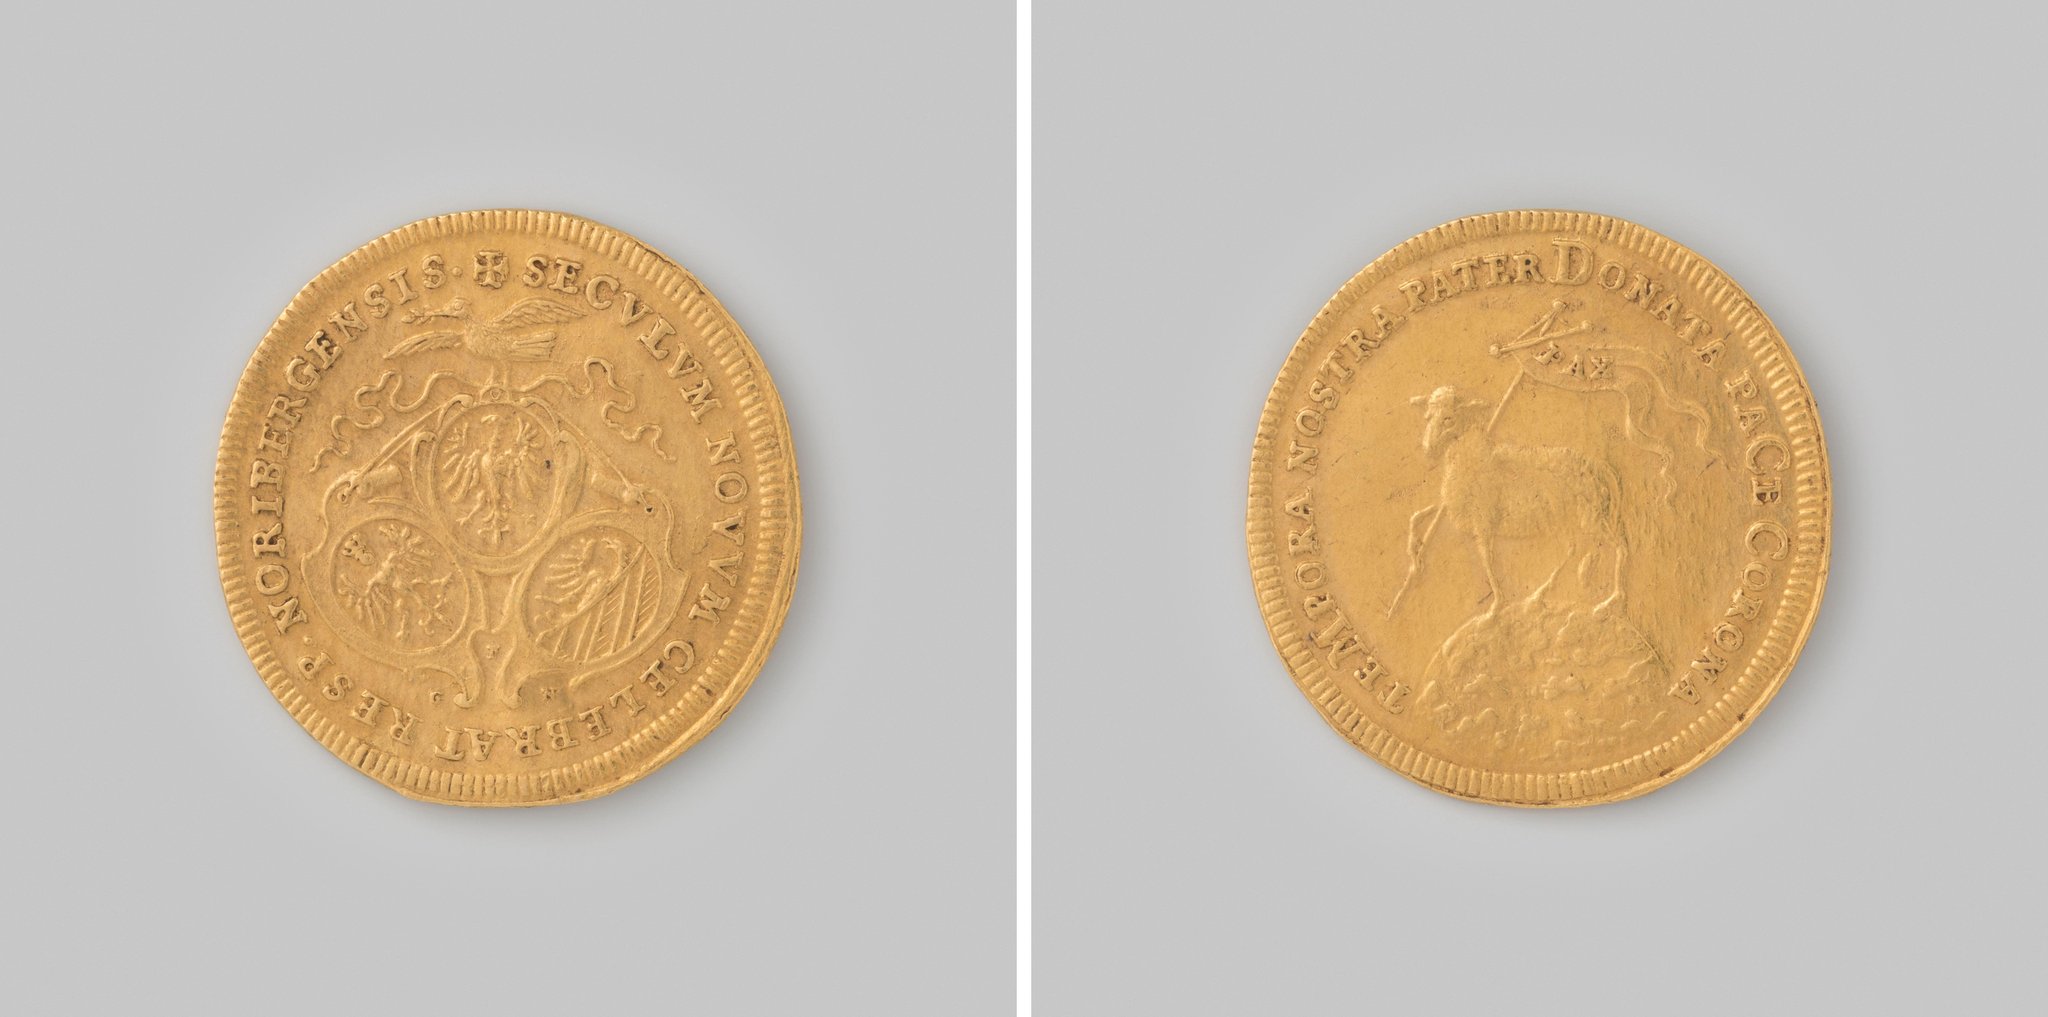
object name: dubbele dukaat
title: 2 Dukaten uit de rijksstad Neurenberg, 1700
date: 1700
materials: gold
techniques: striking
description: Gouden munt. Voorzijde: onder versiering drie samengebonden wapenschilden. Keerzijde: paaslam met vaan, waarin aanduiding PAX, op berg. Jaartal in Romeinse letters gaat schuil in het omschrift. Gladde rand.